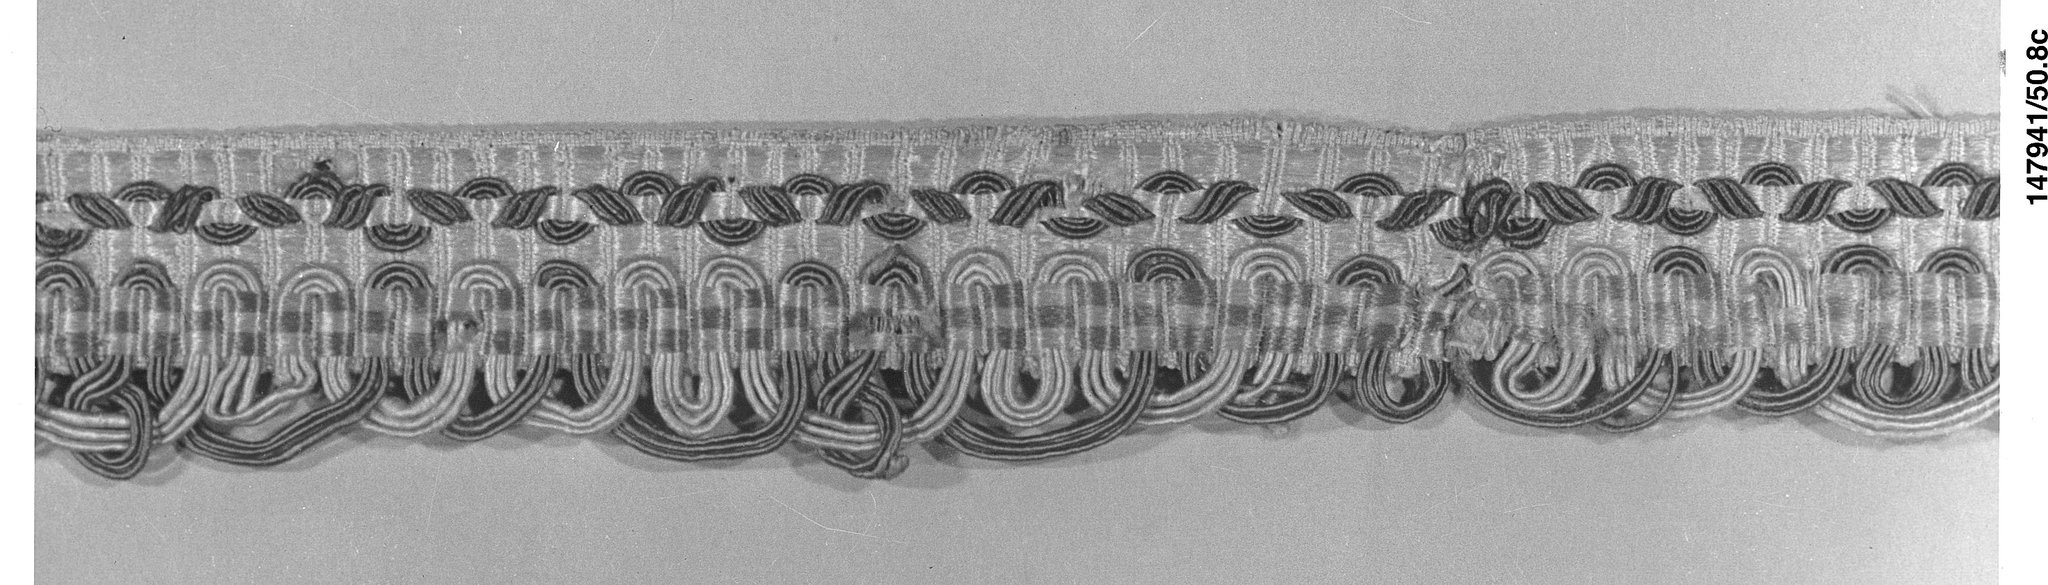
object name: piece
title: Upholstery passementerie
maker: philippe de lasalle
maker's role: designer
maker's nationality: french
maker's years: 1723-1804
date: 1751-1800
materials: silk